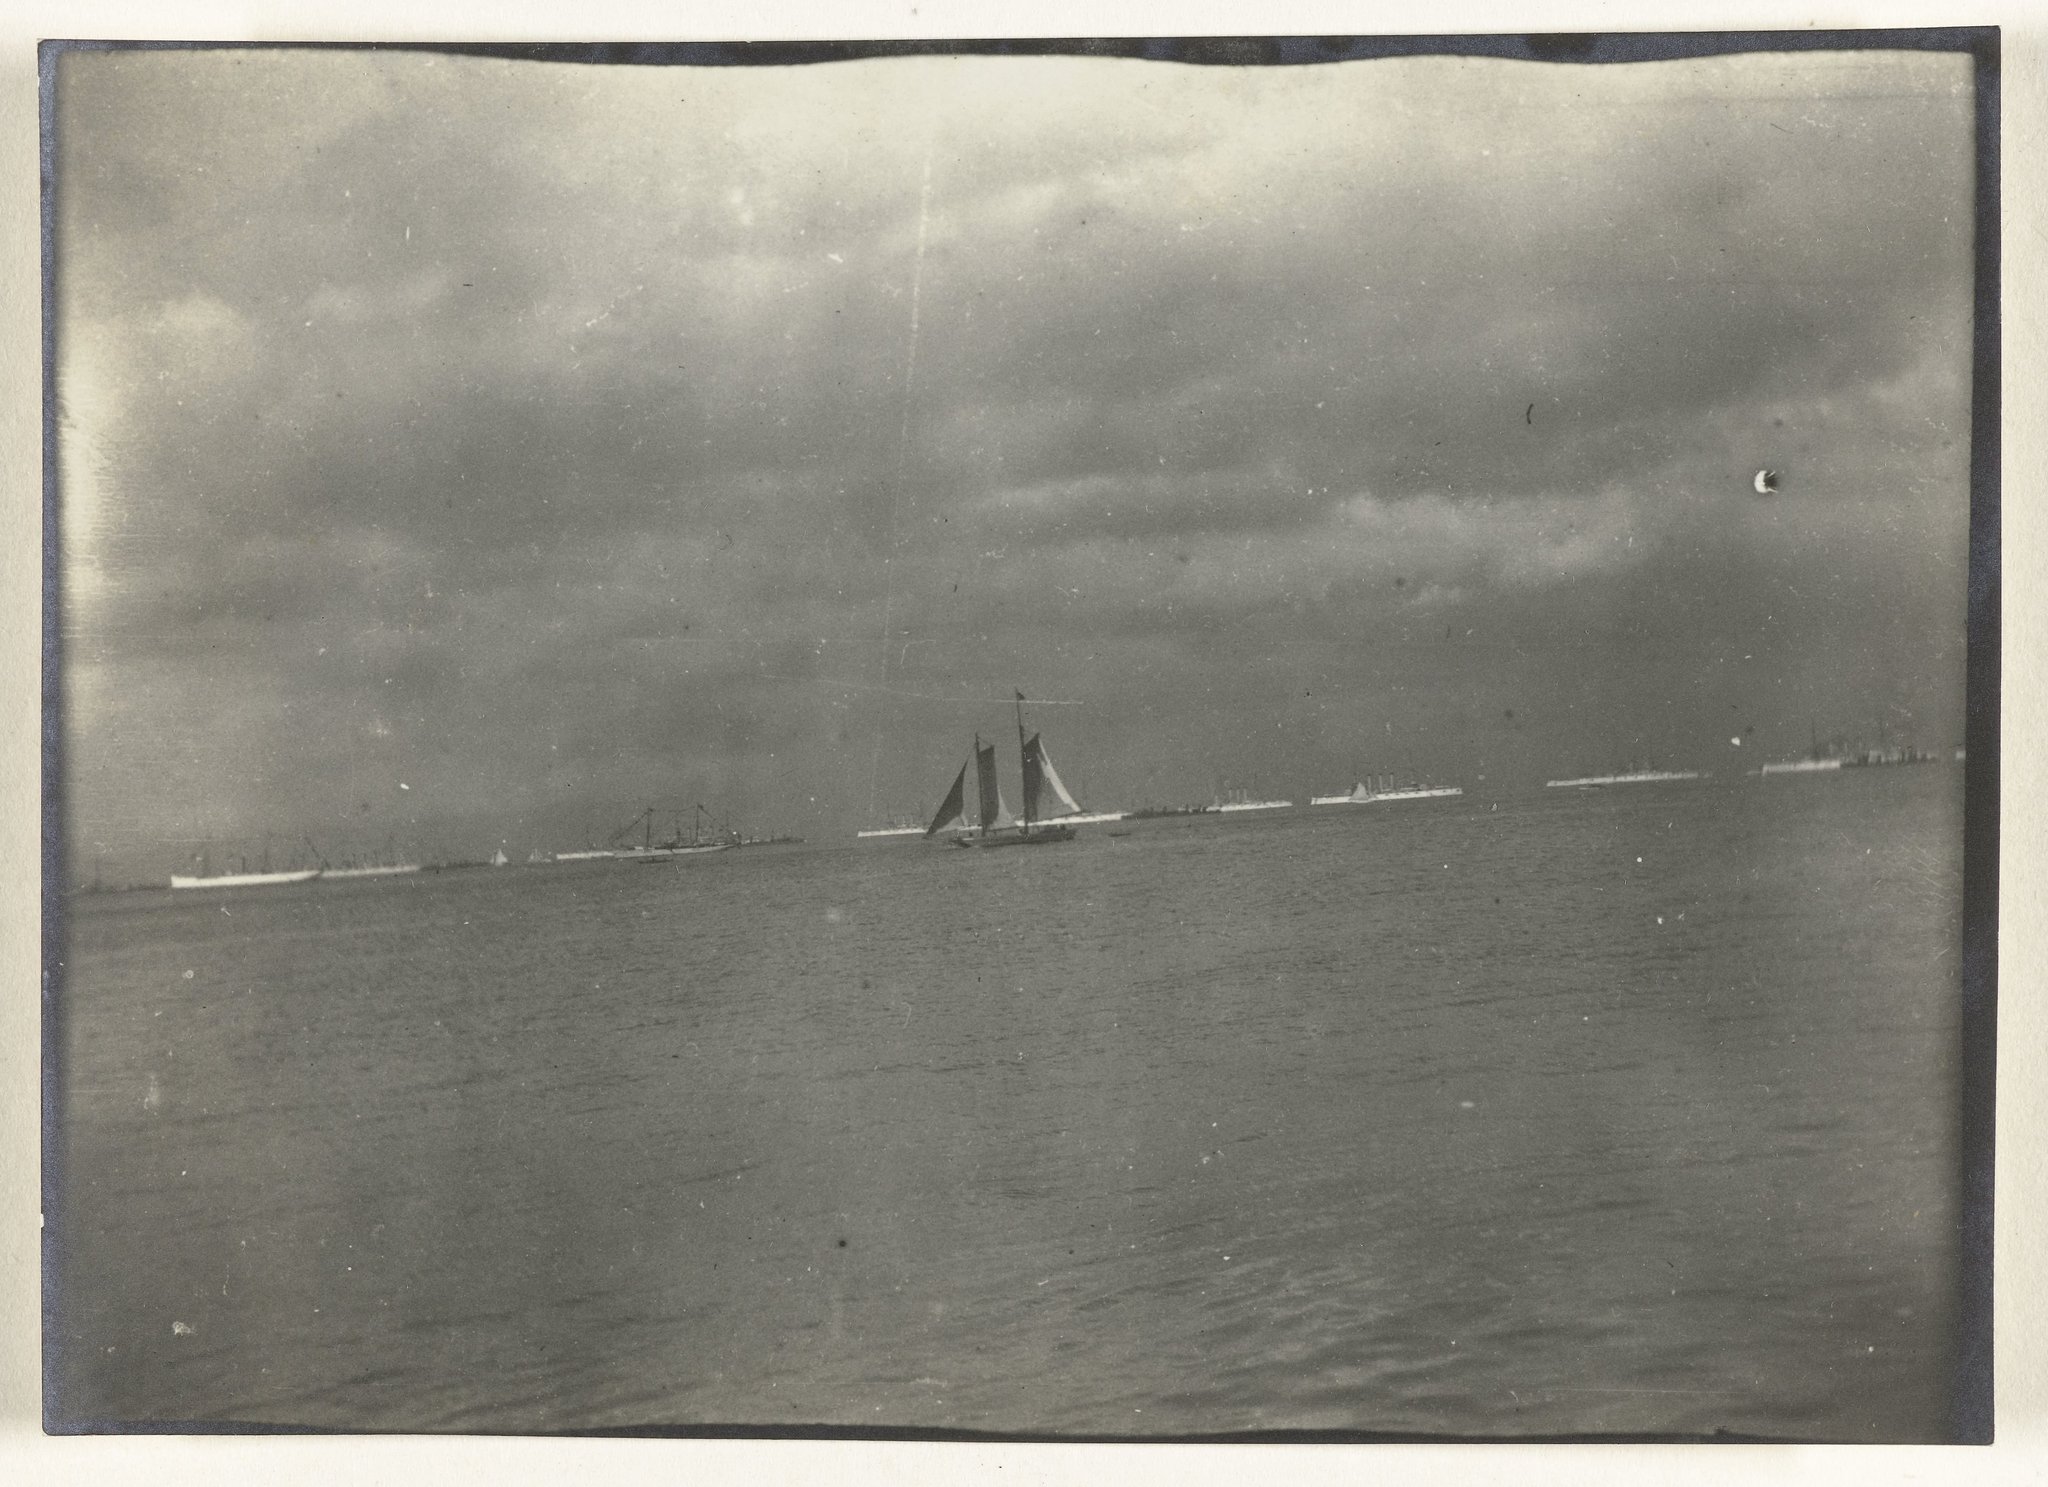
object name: photograph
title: The White Pageant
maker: geldolph adriaan kessler (dolph)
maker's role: fotograaf, industrieel, voetballer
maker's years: 1884-1945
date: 1905-1908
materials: cardboard, photographic support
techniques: gelatin silver print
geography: new york city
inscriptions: title: ‘The White Pageant’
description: Zeilschip The White Pageant. Onderdeel van het fotoalbum van Dolph Kessler met opnamen die hij maakte tijdens zijn verblijf in Engeland en op een wereldreis die hij als secretaris van Henri Deterding (directeur Koninklijke Olie) ondernam naar Nederlands-Indië, Japan, China en de Verenigde Staten, tussen 1906 en 1908.